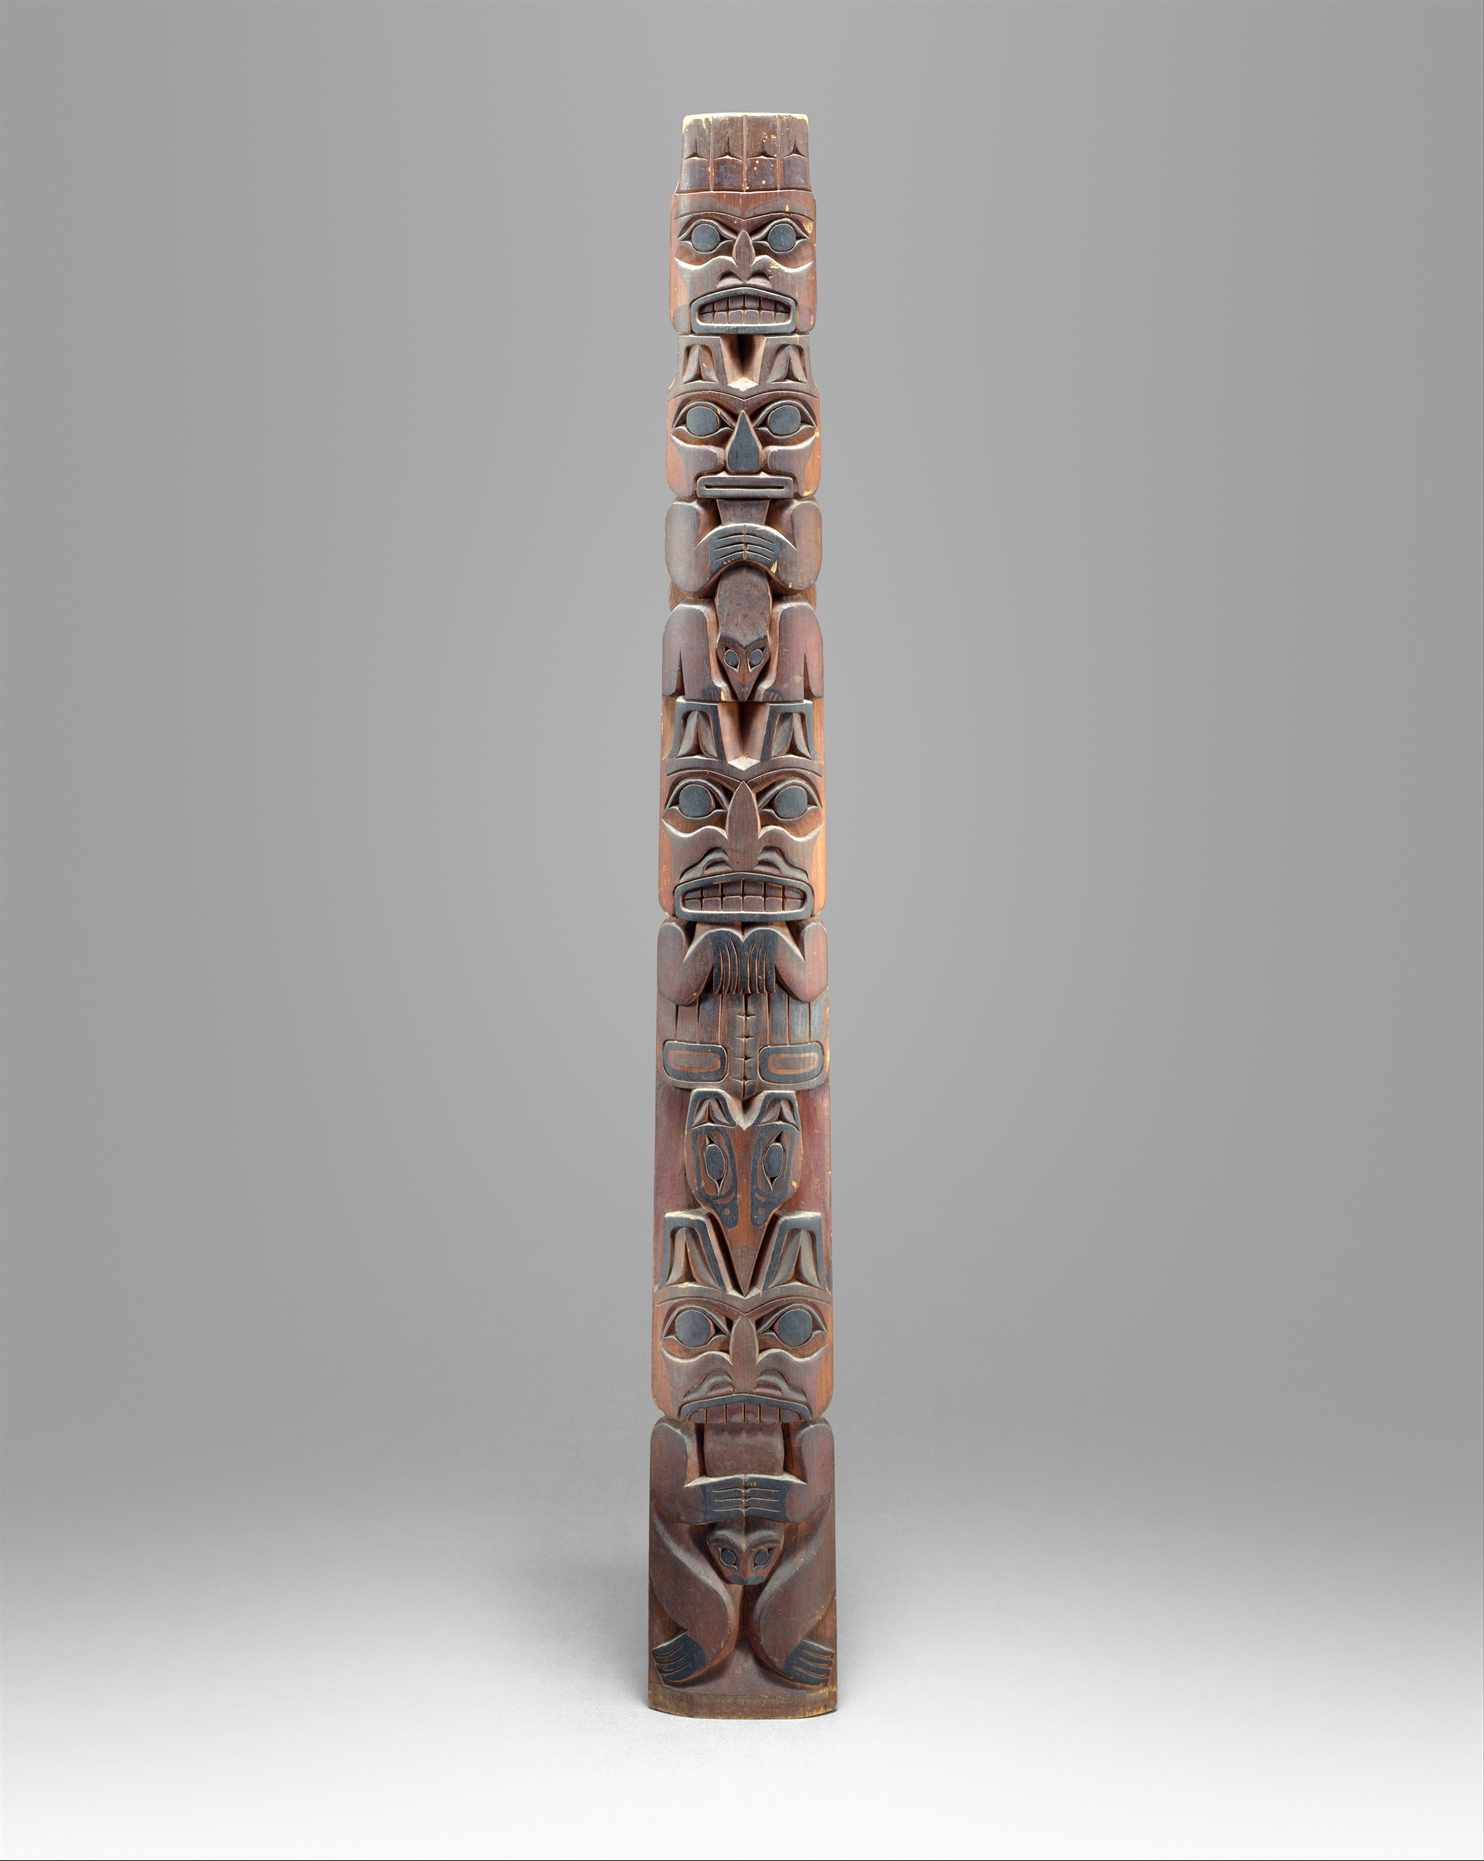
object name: totem pole model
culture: tlingit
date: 1820-1840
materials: wood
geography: united states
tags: human figures